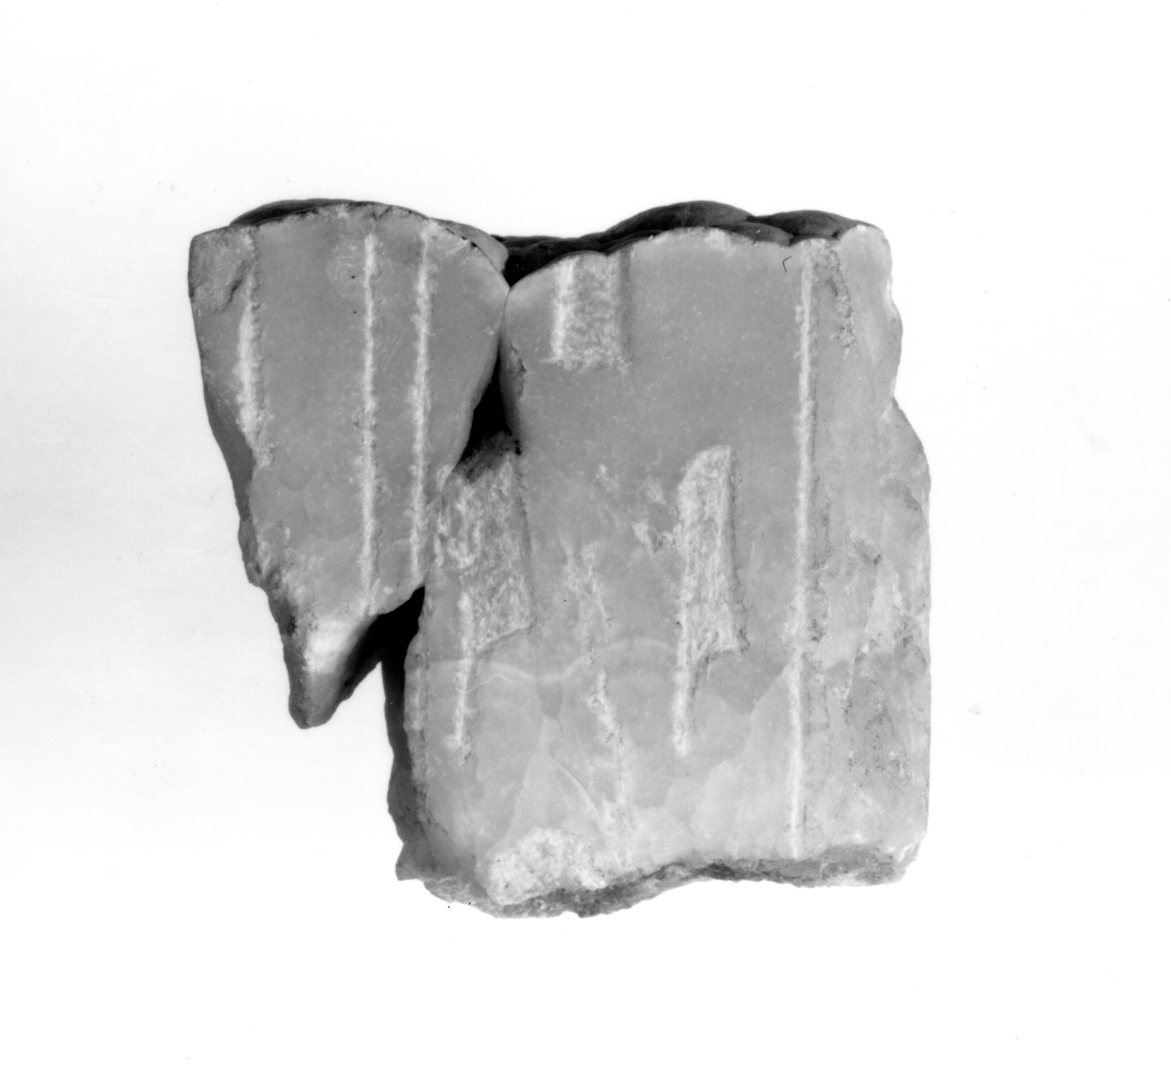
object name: canopic chest, tiye, thutmose iv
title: Fragment of a Canopic Chest of Queen Tiya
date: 1427-1390 BCE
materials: stone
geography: egypt